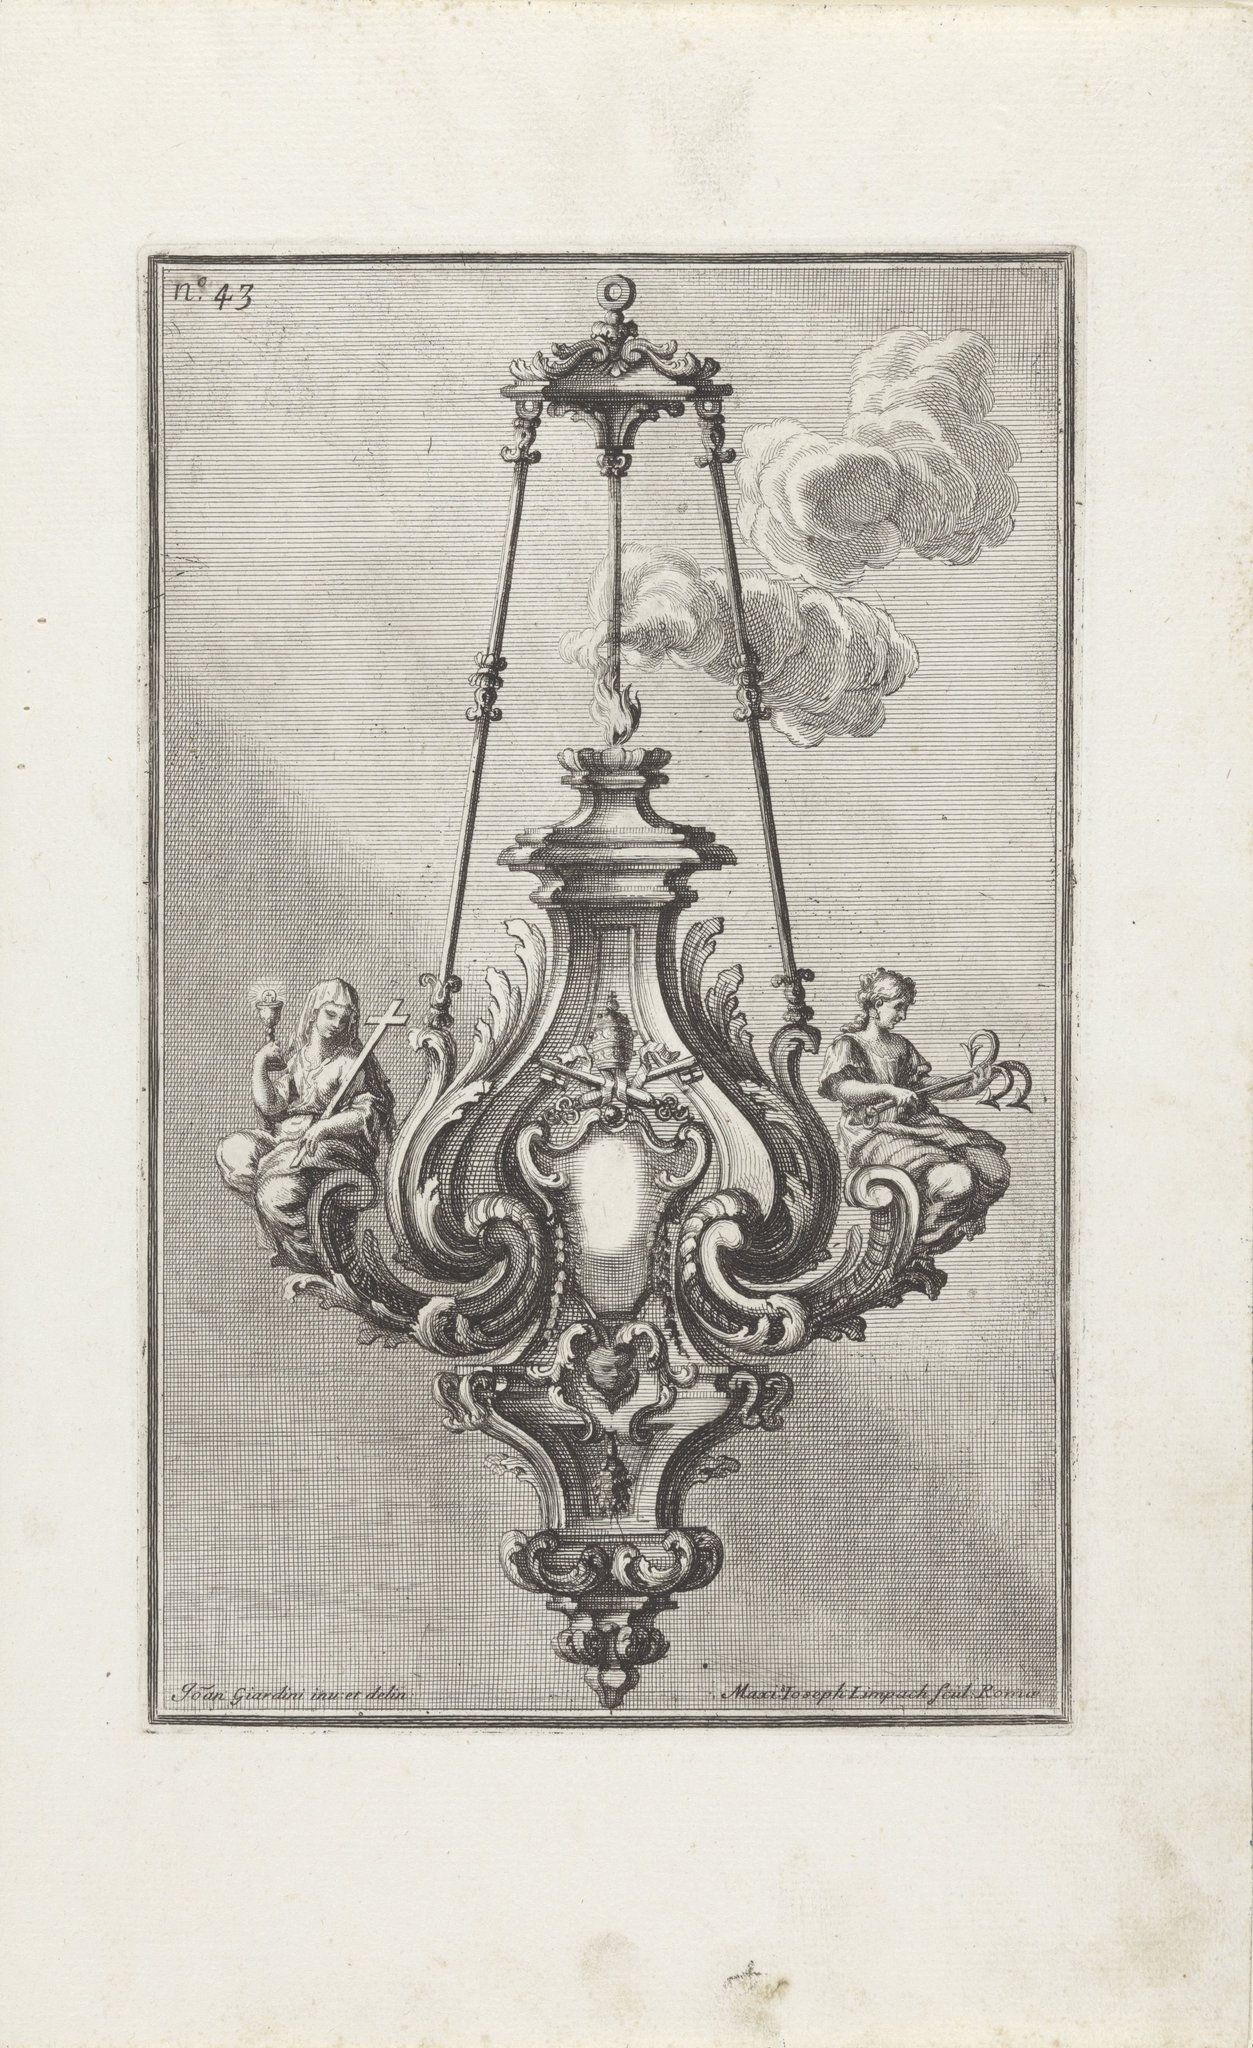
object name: ornament print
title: Kroonluchter met personificaties van Hoop en Geloof en pauselijk wapen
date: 1714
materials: paper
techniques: etching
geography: italy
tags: faith, 'fides'; 'fede', 'fede catholica', 'fede christiana', 'fede christiana catholica' (ripa) ~ one of the three theological virtues, hope, 'spes'; 'speranza divina e certa' (ripa) ~ one of the three theological virtues, chandelier, candelabrum, candle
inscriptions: collector's mark: Lugt 2228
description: Prent maakt deel uit van een reeks van 100 ornamentprenten naar ontwerp van Giovanni Giardini.